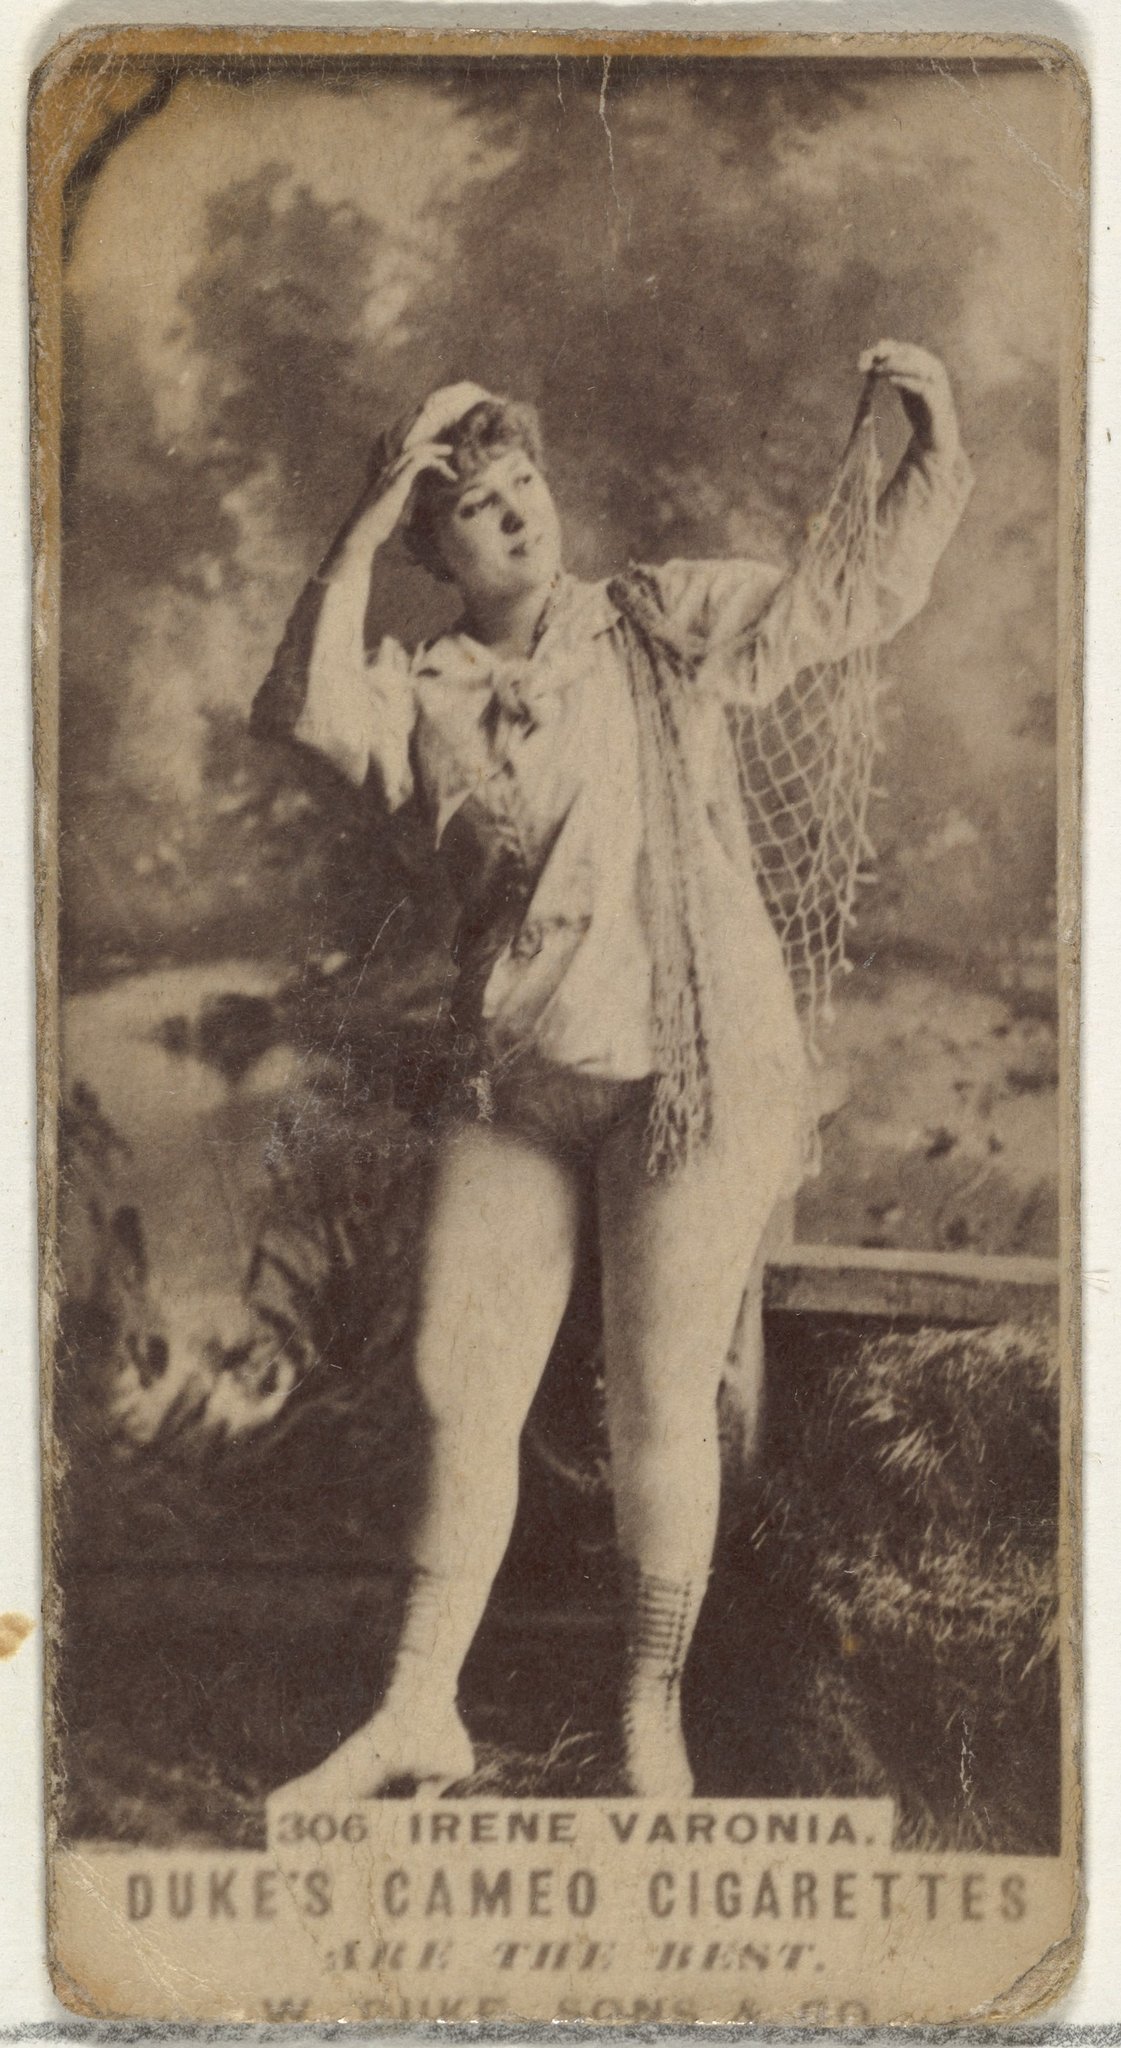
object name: photograph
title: Card Number 306, Irene Verona, from the Actors and Actresses series (N145-5) issued by Duke Sons & Co. to promote Cameo Cigarettes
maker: w. duke, sons & co.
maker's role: publisher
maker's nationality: american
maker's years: 1870-1920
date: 1880-1889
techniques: albumen silver print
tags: portraits,women,actresses